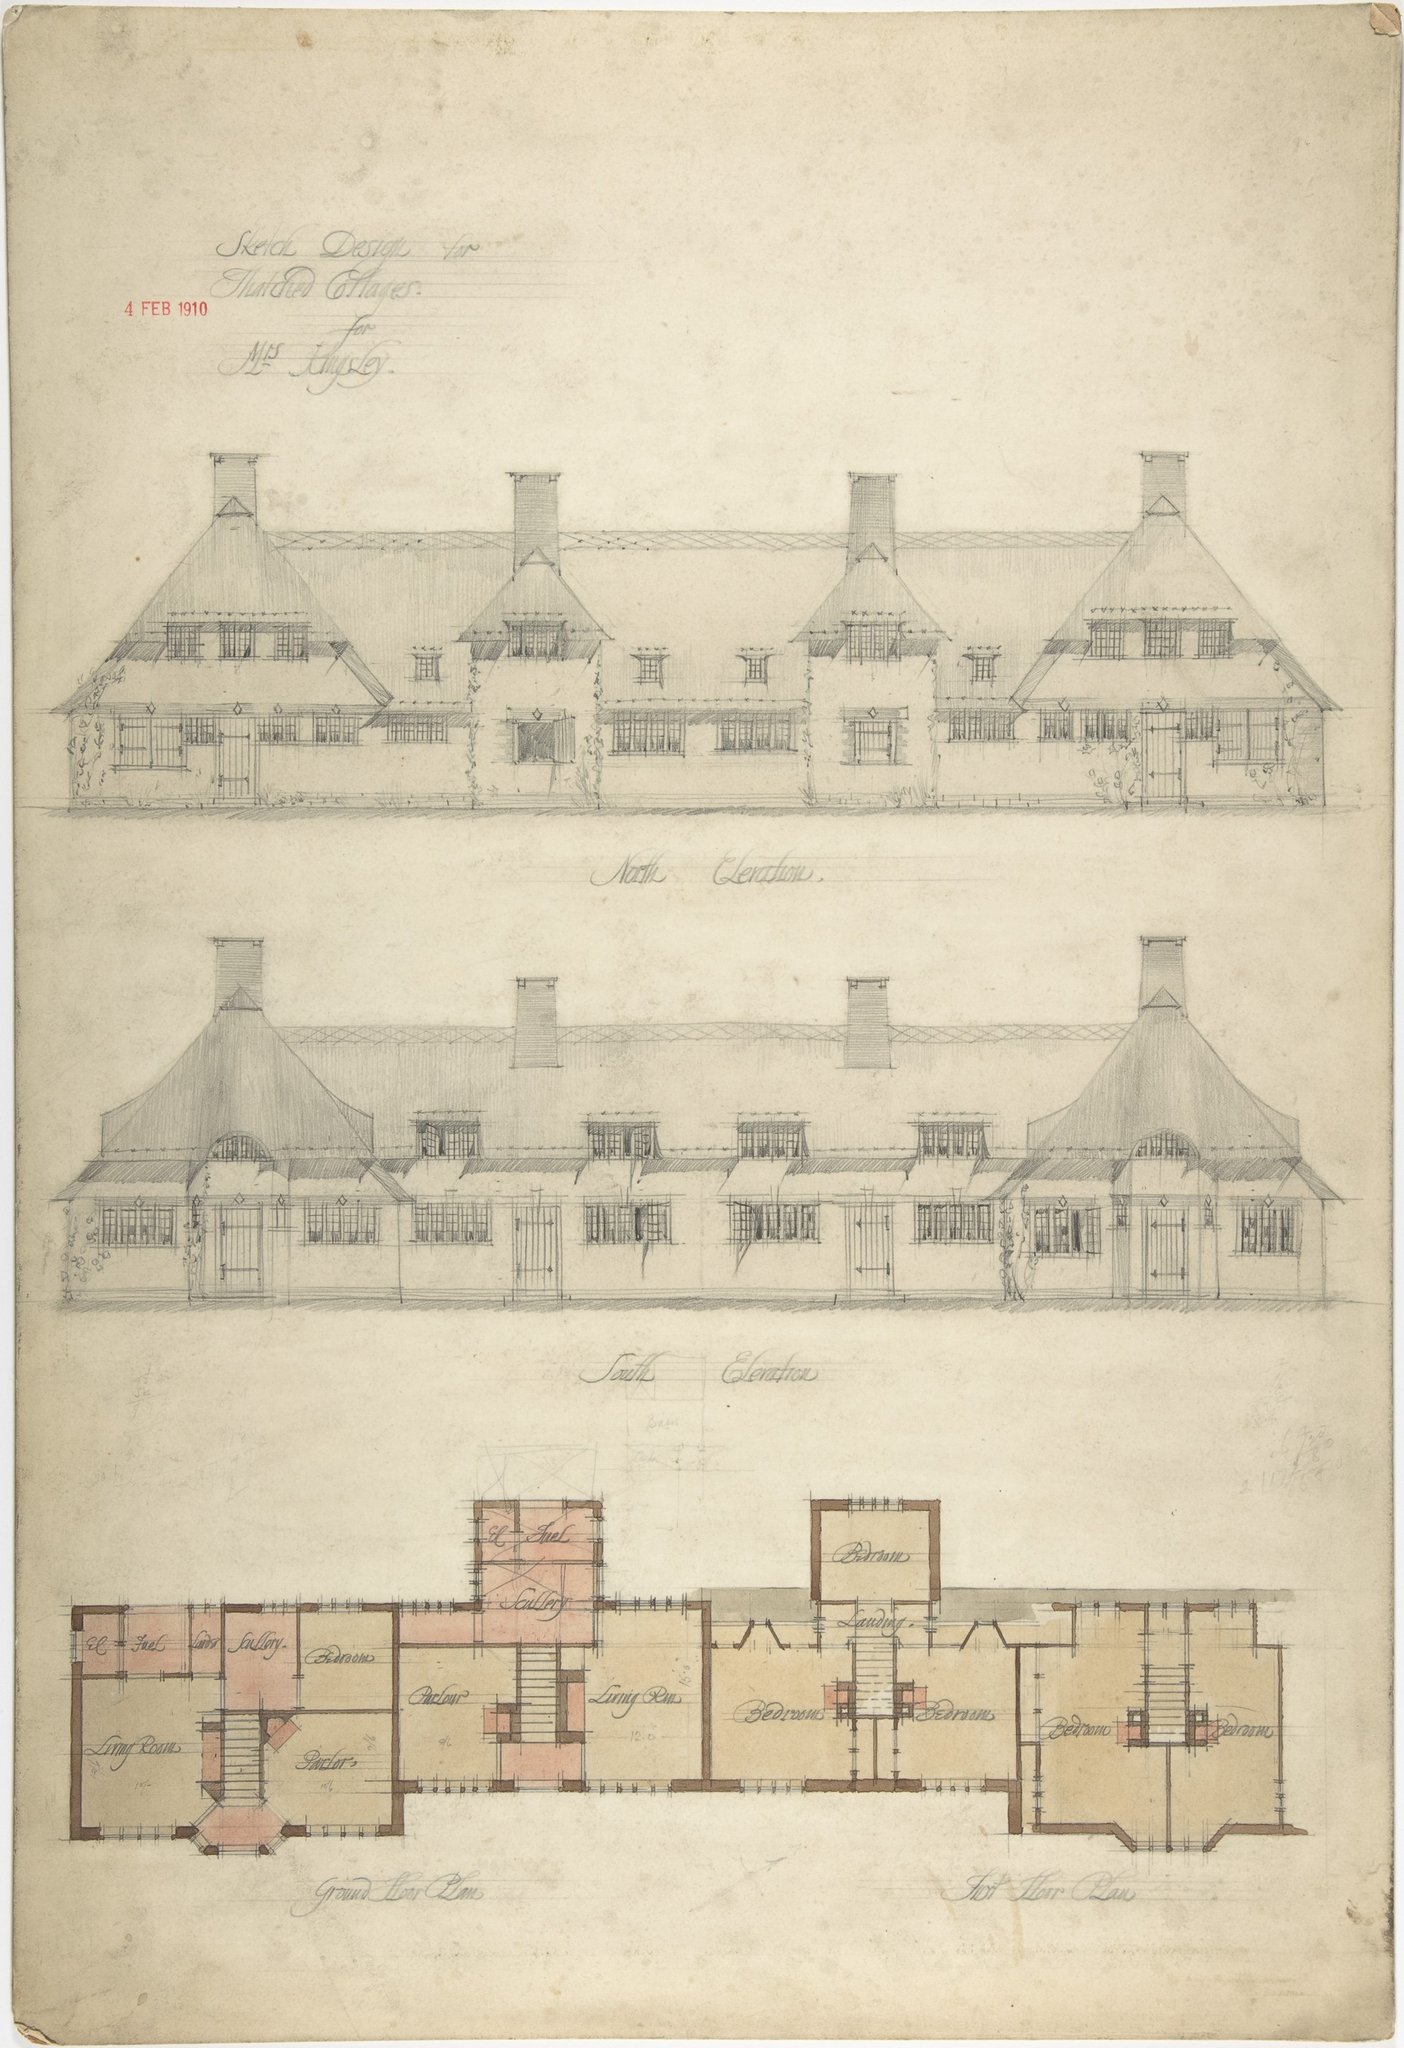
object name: drawing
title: Design for Thatched Cottages for Mrs. Kingsley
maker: charles edward mallows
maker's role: artist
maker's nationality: british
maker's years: 1864-1915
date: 1910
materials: graphite, ink, watercolor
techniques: pen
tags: buildings